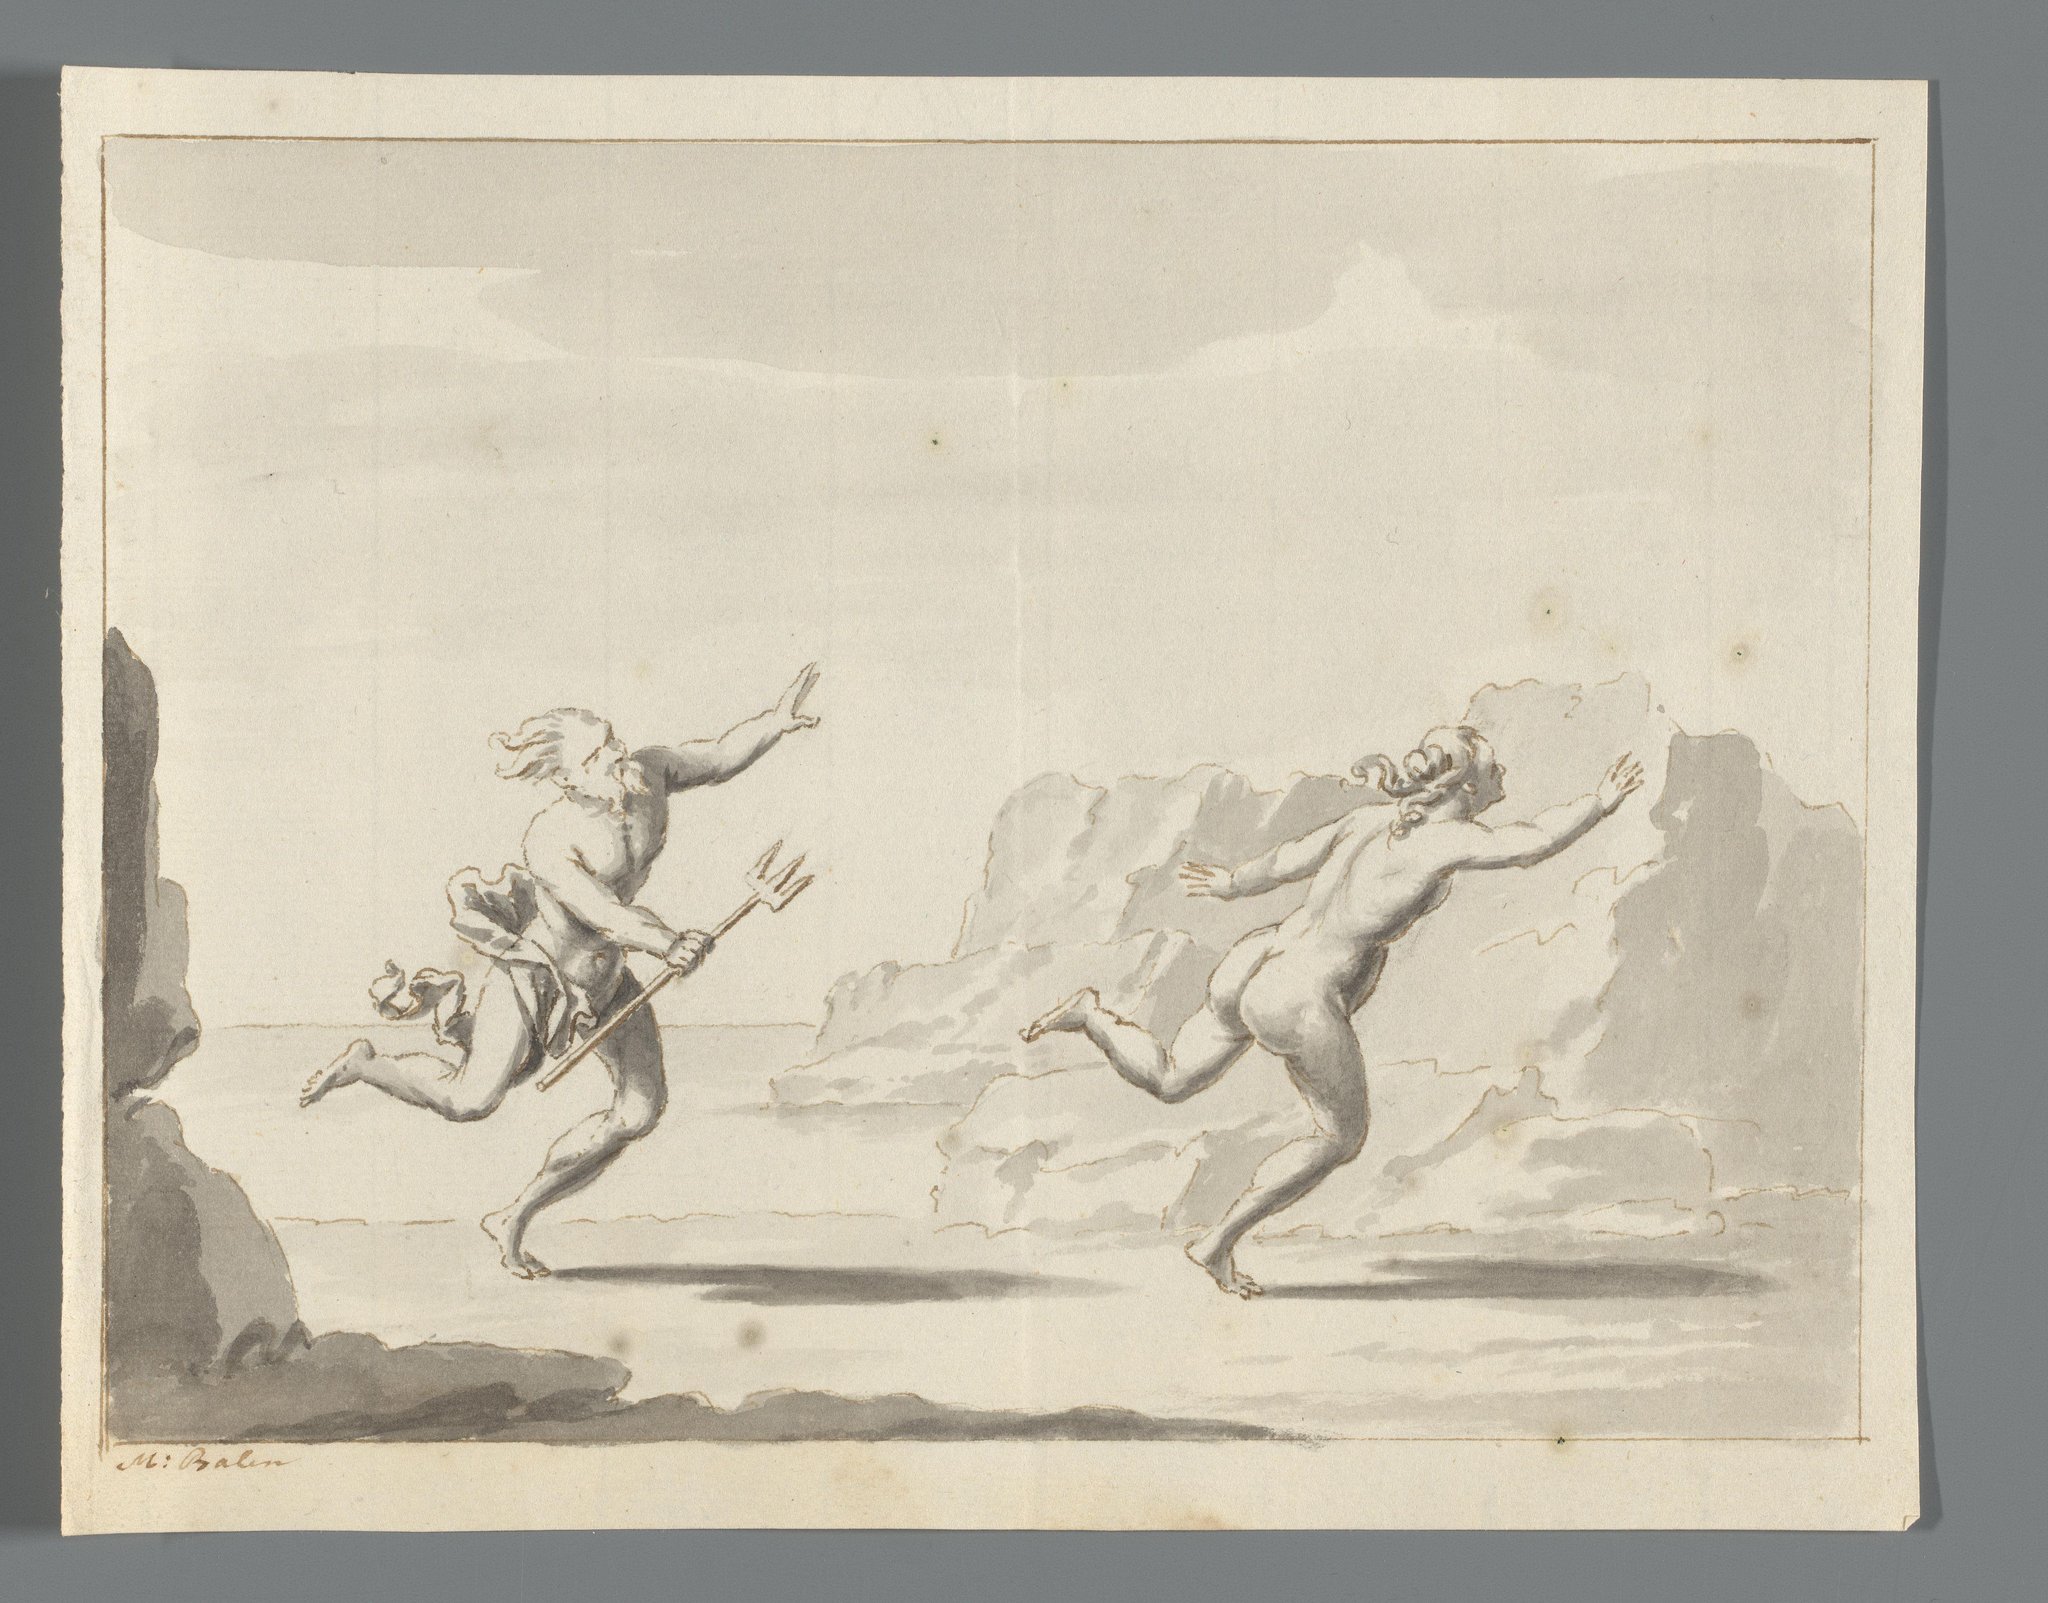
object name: drawing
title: Neptunus en mogelijk Coronis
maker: matthijs balen (1684-1766)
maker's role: draughtsman, painter, print maker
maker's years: 1684-1766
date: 1694-1766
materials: paper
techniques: brush, pen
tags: (story of) neptune (poseidon), coronis changed into a crow: to escape the love of neptune, coronis, daughter of coroneus, is changed into a crow by minerva (ovid, metamorphoses ii 569)